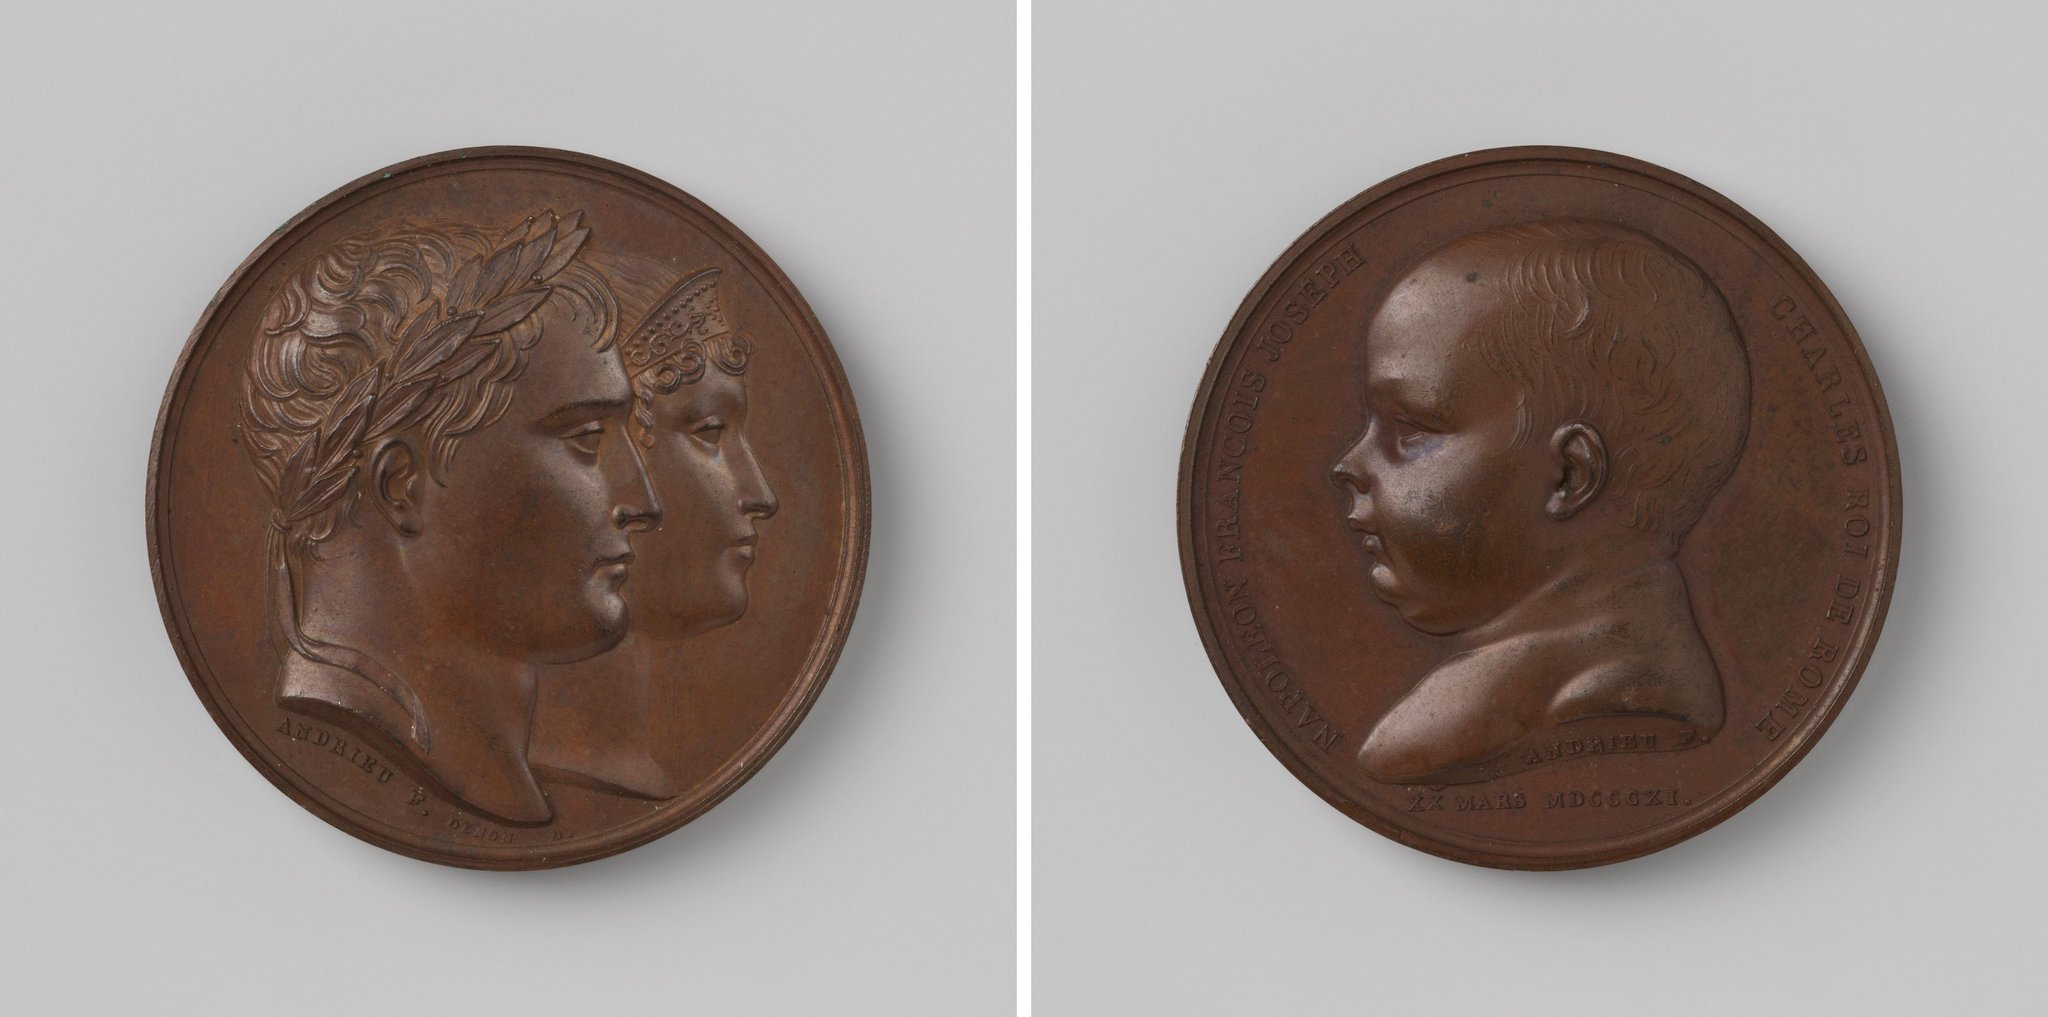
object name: history medal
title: Geboorte van Napoleon Frans Karel Jozef, zoon van Napoleon I Bonaparte en Marie Louise, keizer en keizerin der Fransen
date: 1811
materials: bronze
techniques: striking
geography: paris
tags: napoleon i (emperor of the french), vienna, marie louise van oostenrijk (keizerin der fransen), paris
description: Bronzen penning. Voorzijde: borststuk man met lauwerkrans en vrouw met diadeem binnen omschrift. Keerzijde: borststuk kind binnen omschrift